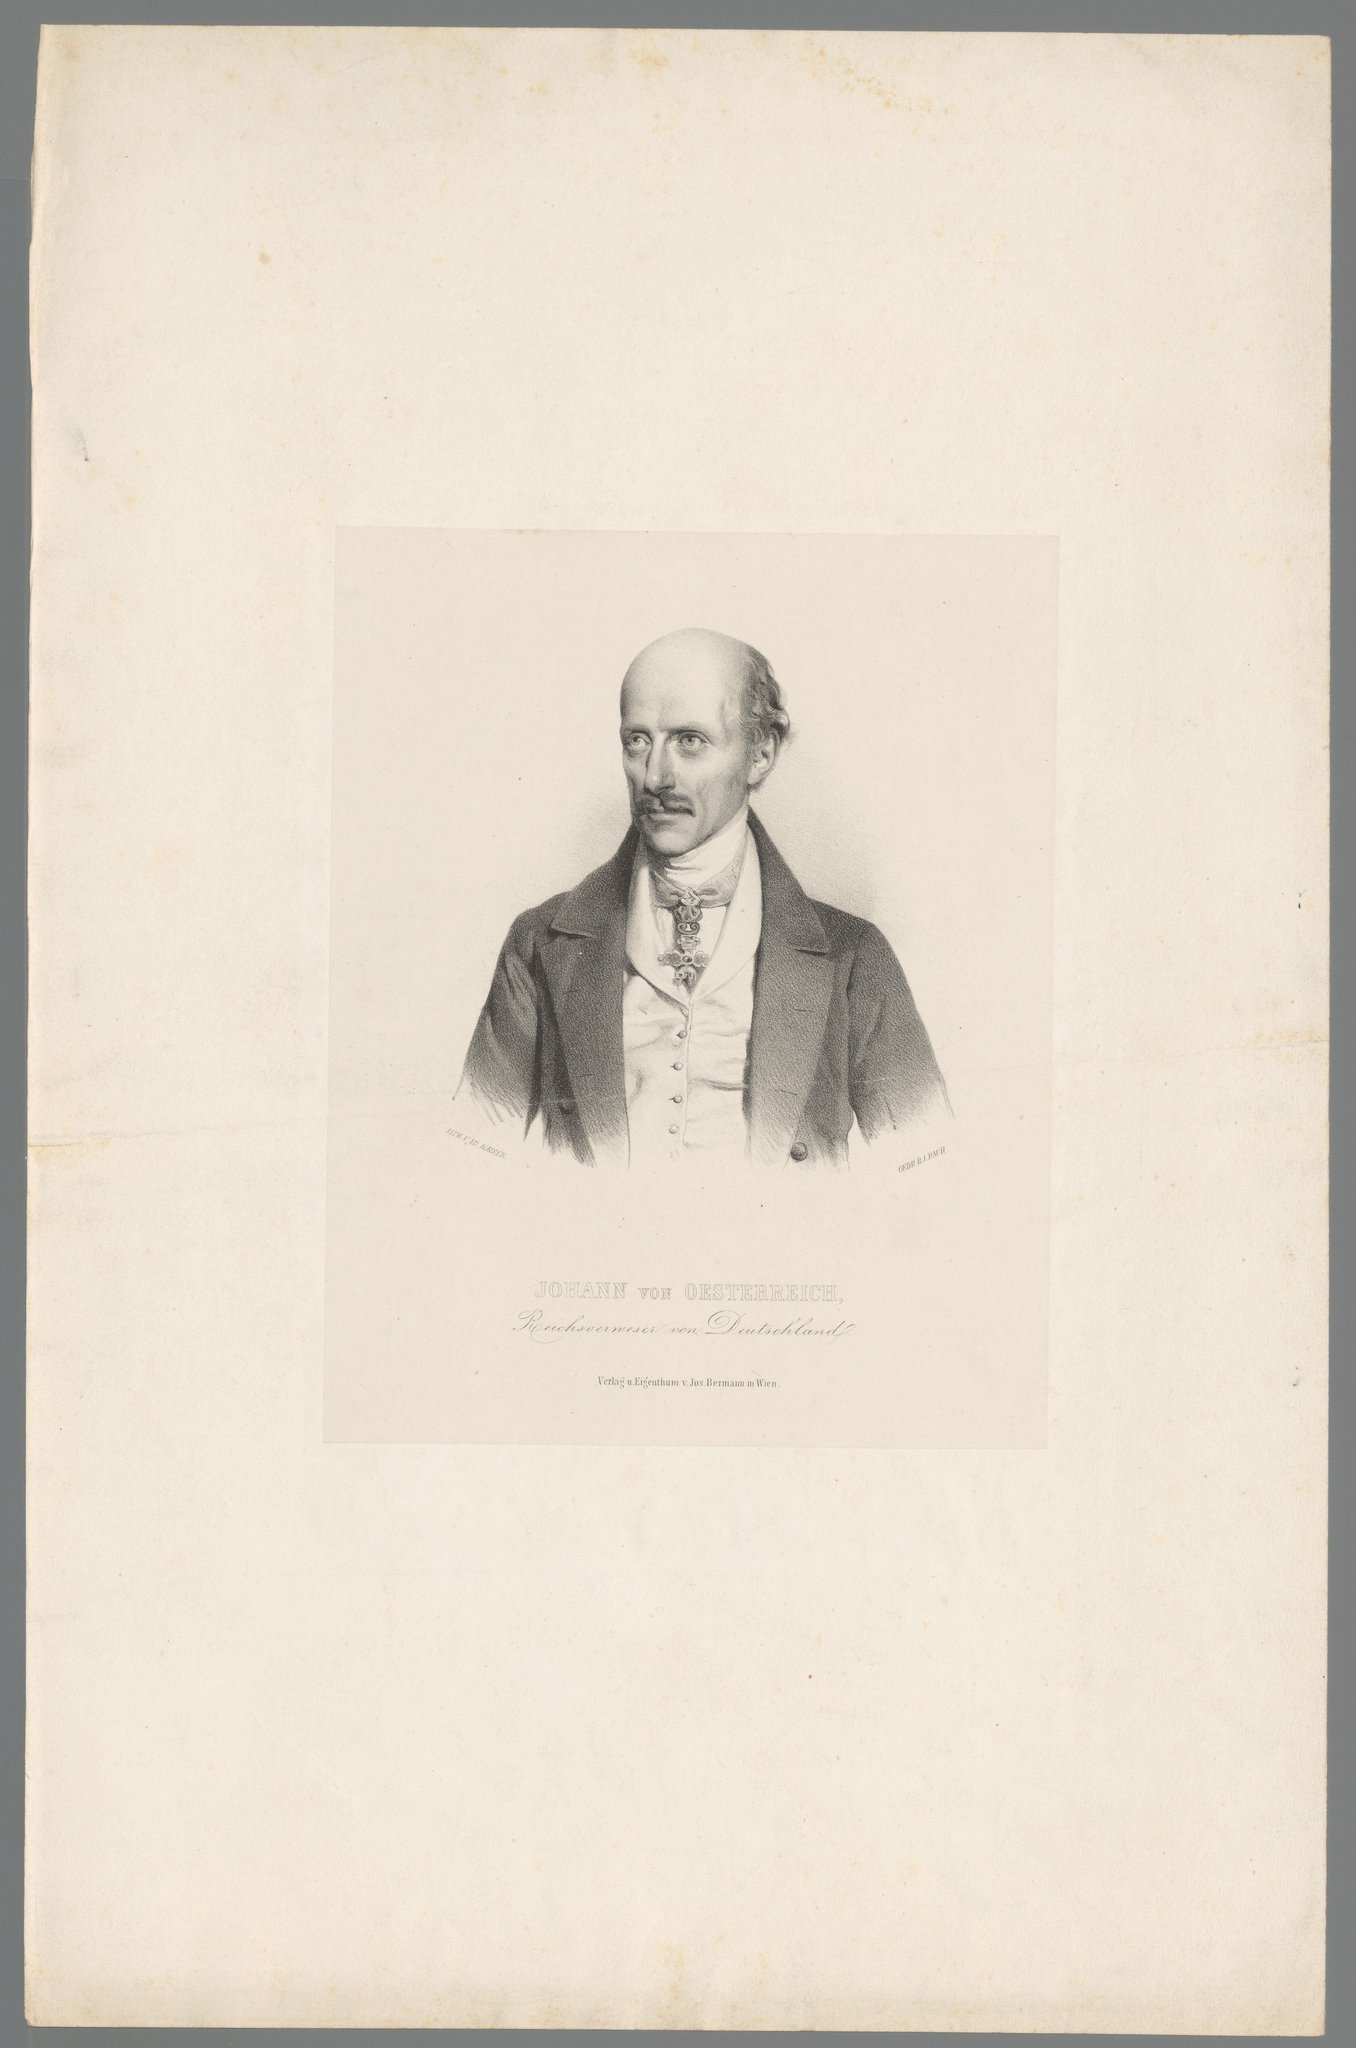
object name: print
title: Portret van Johann, aartshertog van Oostenrijk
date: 1840-1860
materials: paper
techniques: lithograph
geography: vienna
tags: moustache, adult man, historical persons, knighthood order of the golden fleece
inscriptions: collector's mark: Lugt 2228